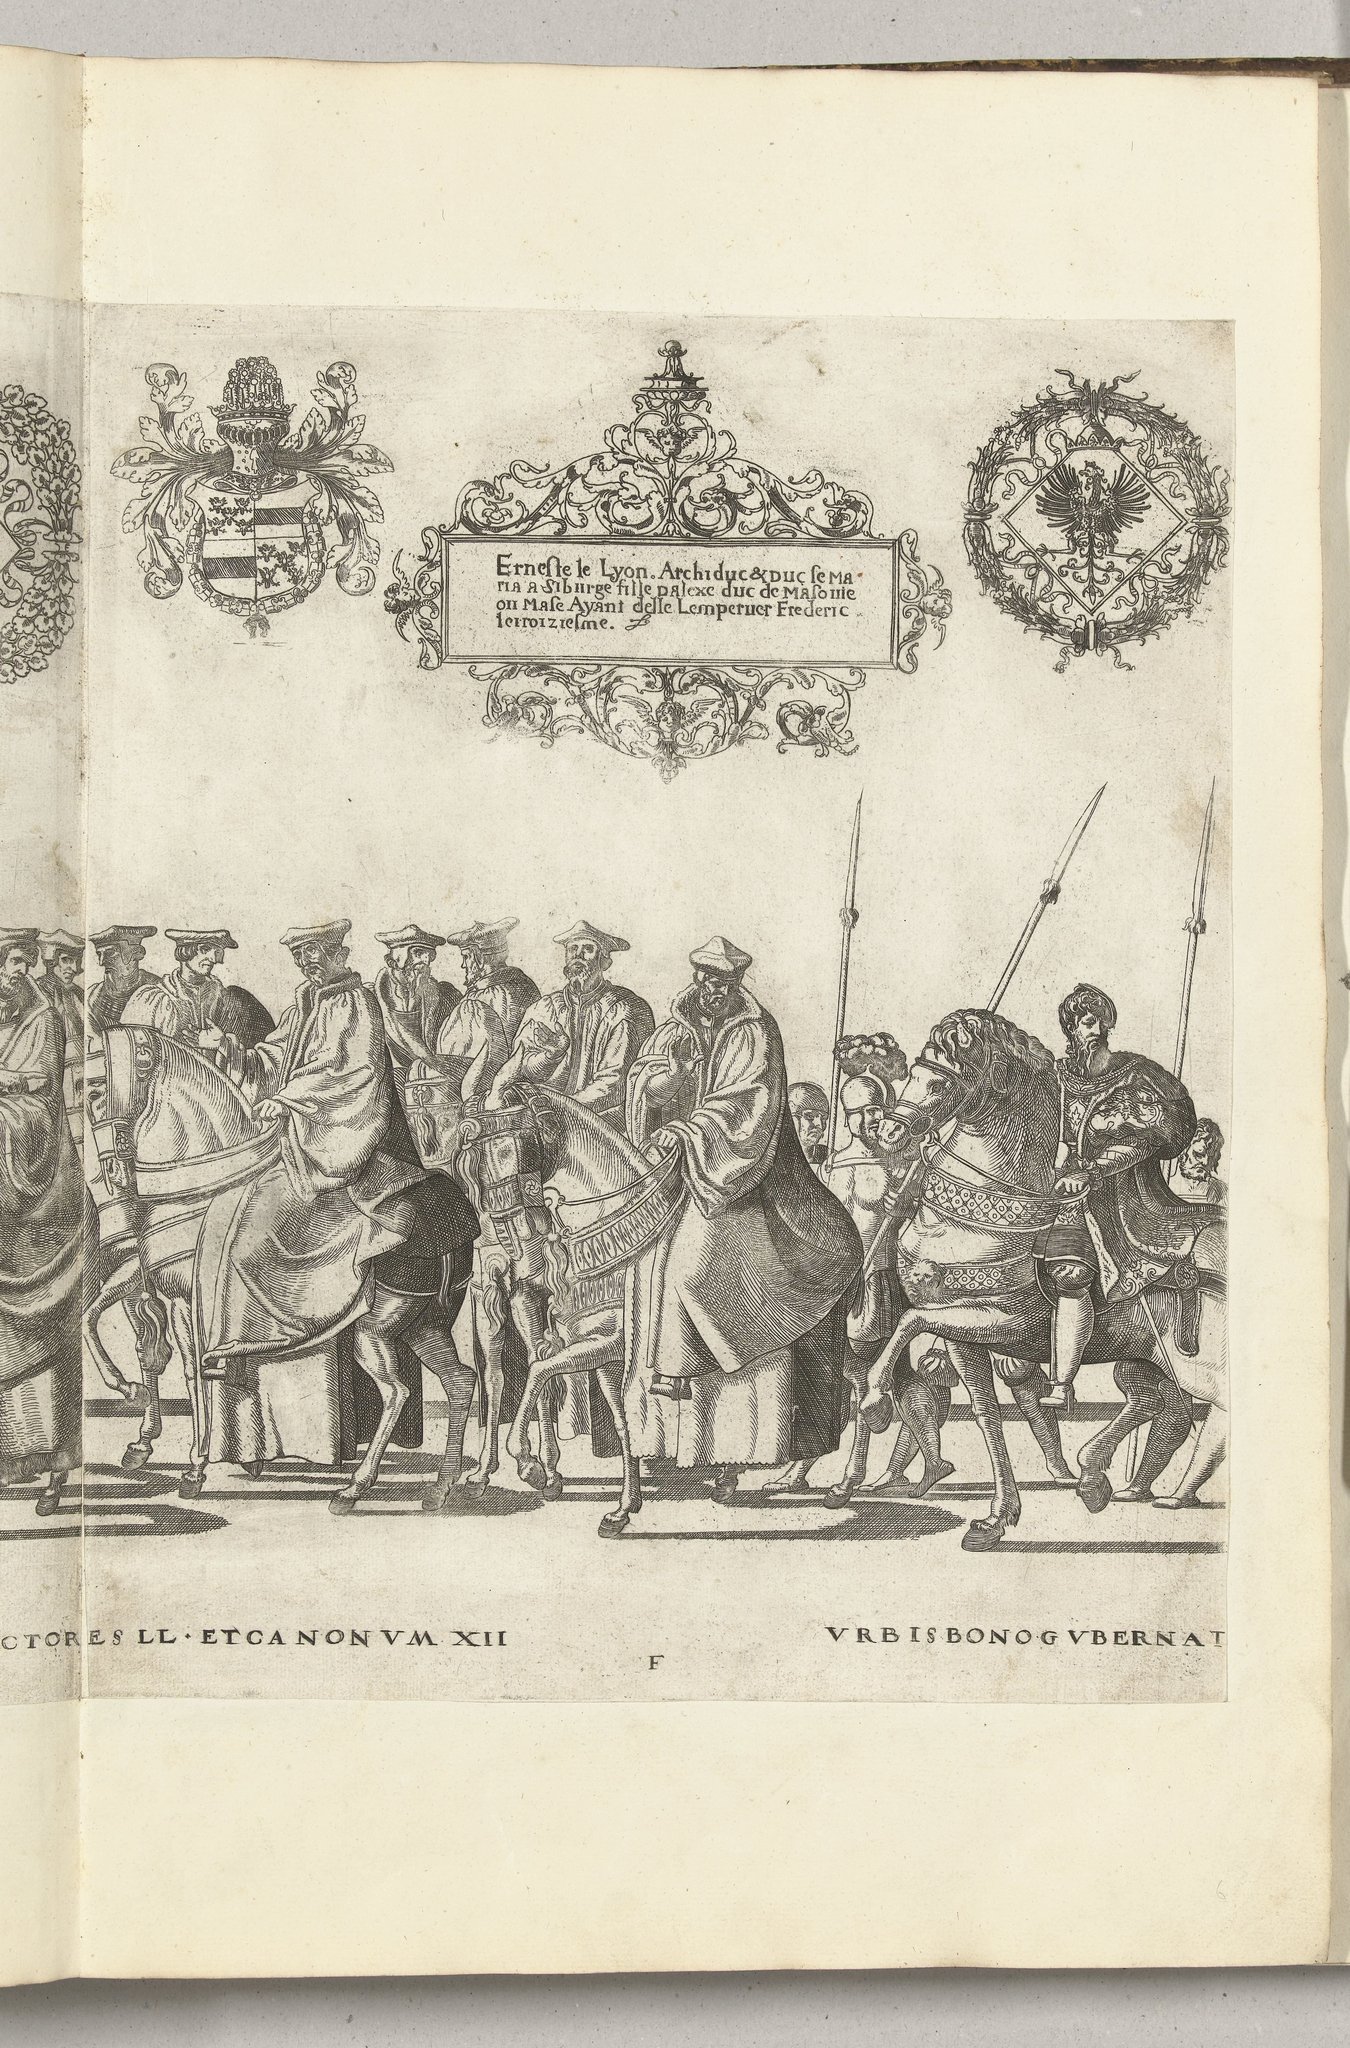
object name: print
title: Vaandeldragers en kanunninken, plaat F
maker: nicolaas hogenberg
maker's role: draughtsman, painter, print maker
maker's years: 1500-1539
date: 1530-1536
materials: paper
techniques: etching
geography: mechelen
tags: ghent, charles v (holy roman emperor and king of spain), rome, festivities (+ parade, pageant, cavalcade ~ festive activities)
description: Prent in het album waarin zijn ingeplakt de 40 platen die achterelkaar samen het fries vormen van de optocht van Karel V met de paus Clemens VII te Bologna na zijn kroning tot keizer, 24 februari 1530.